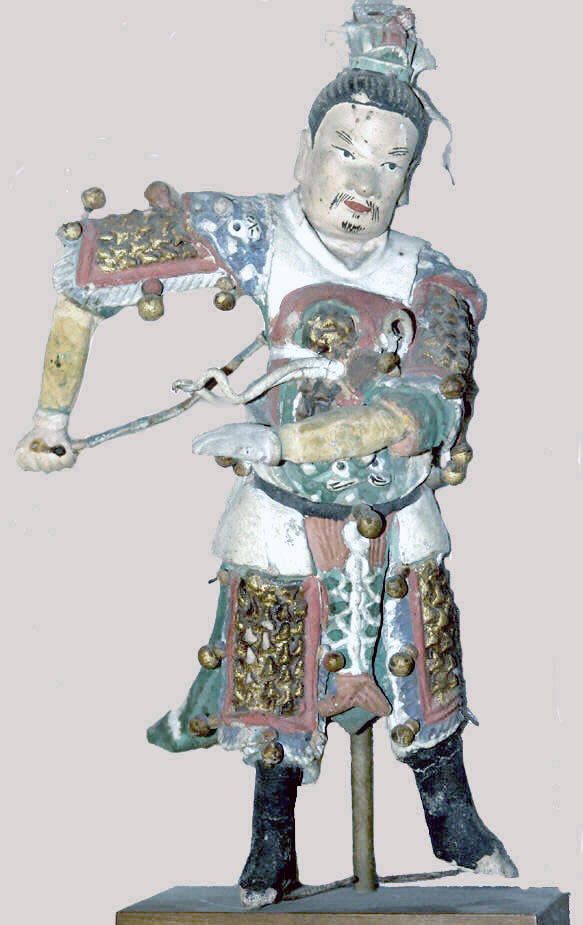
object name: statuette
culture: chinese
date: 1601-1700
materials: mud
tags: men